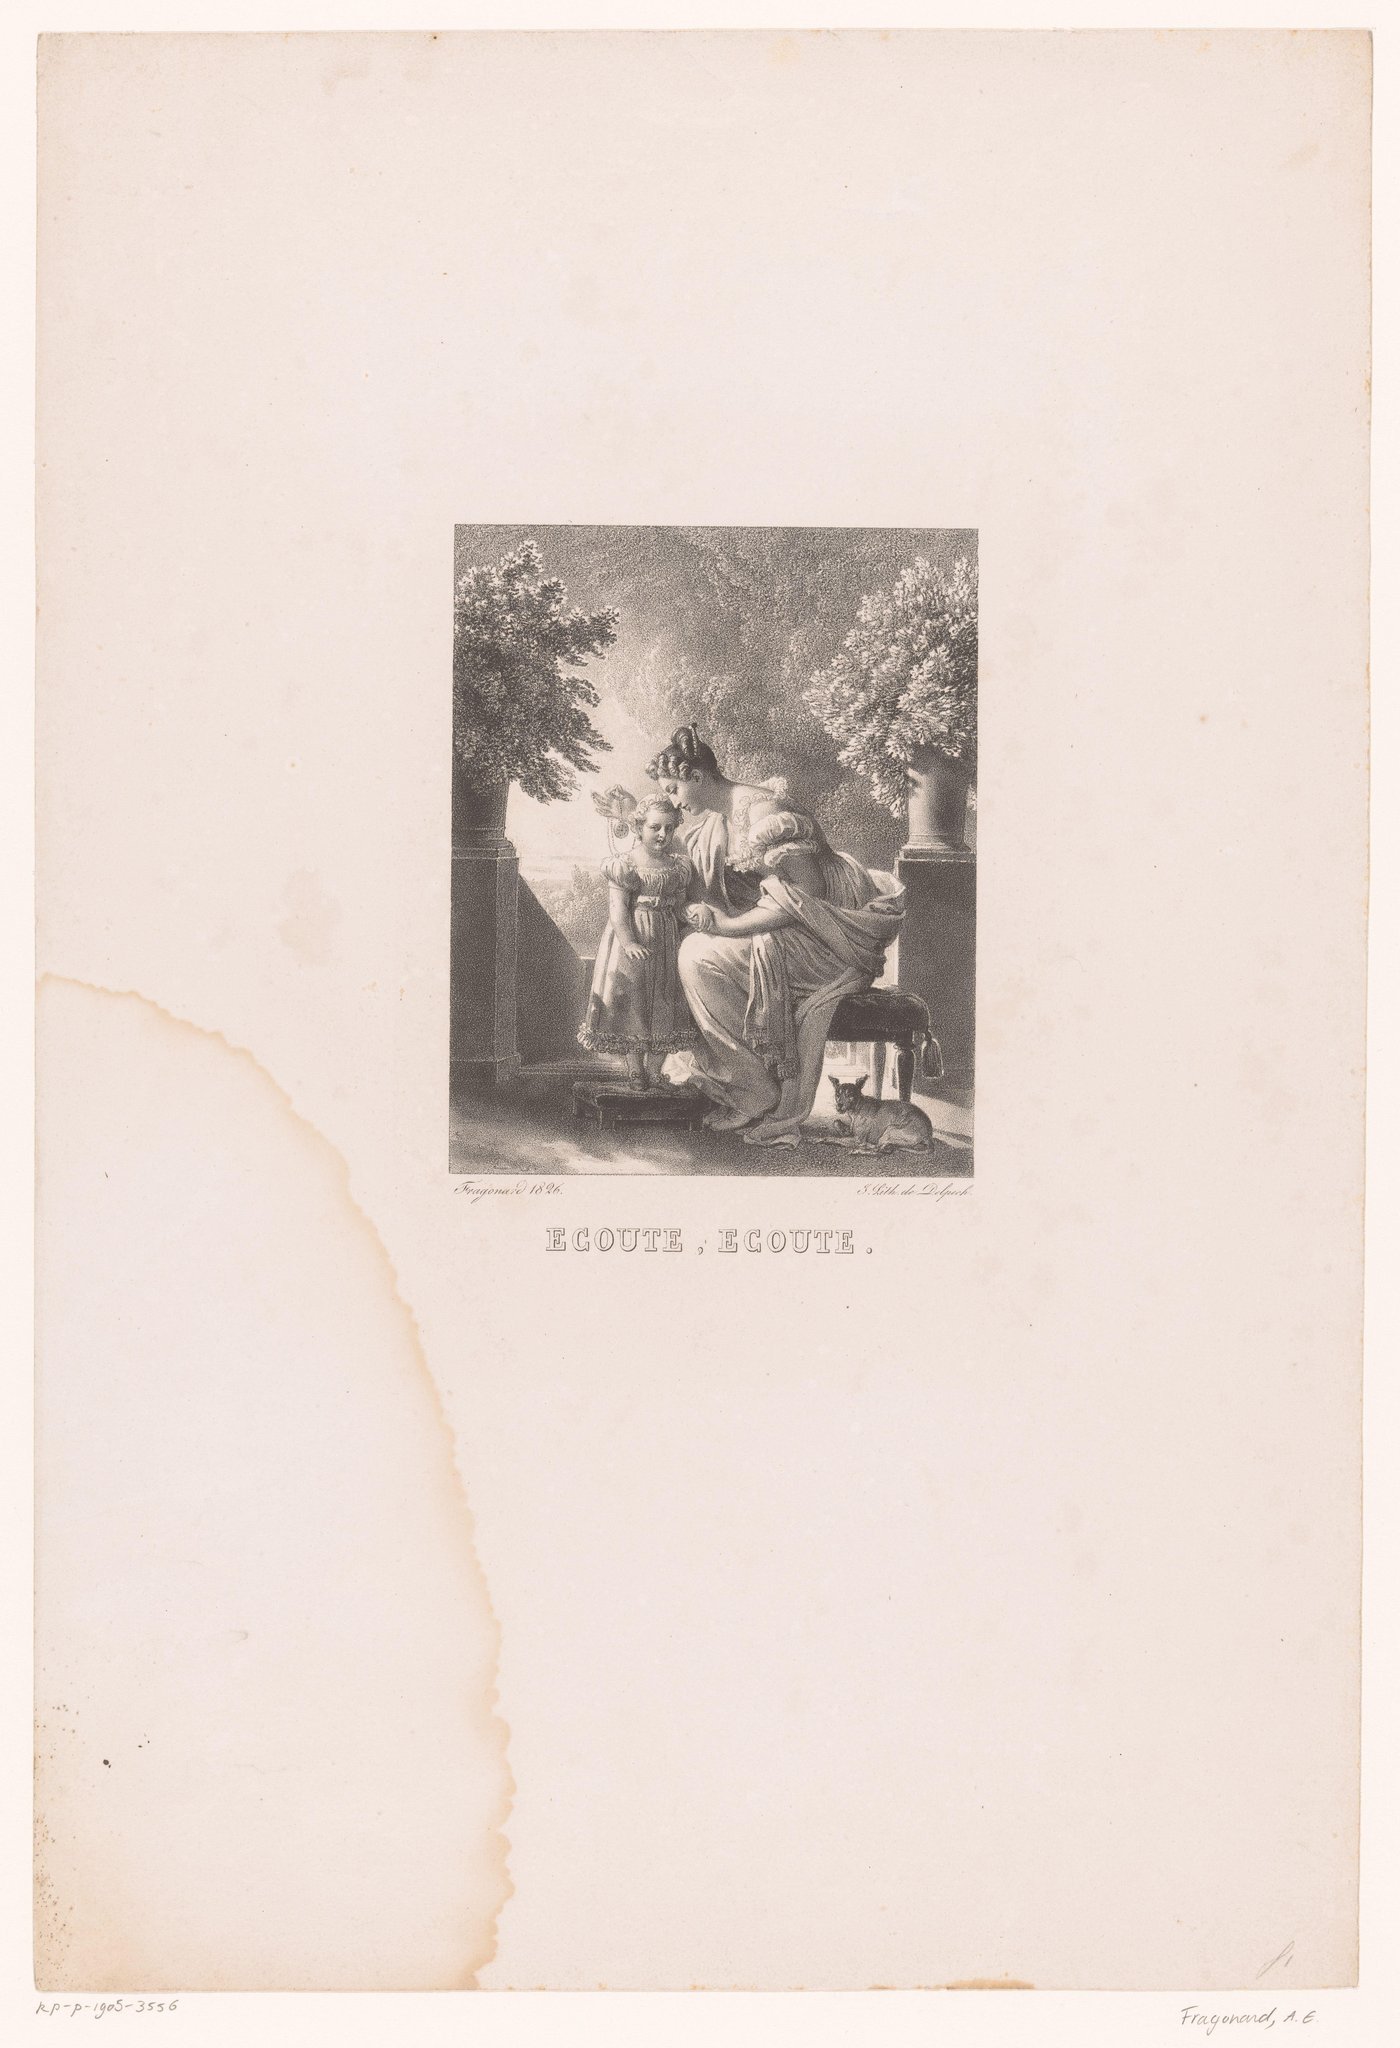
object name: print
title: Moeder laat jong kind luisteren naar een horloge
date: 1826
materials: paper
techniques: lithograph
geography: paris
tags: mother and baby or young child, watch, mother and child(ren), woman and child(ren) (family group) (with number of children)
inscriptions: collector's mark: Lugt 2228a